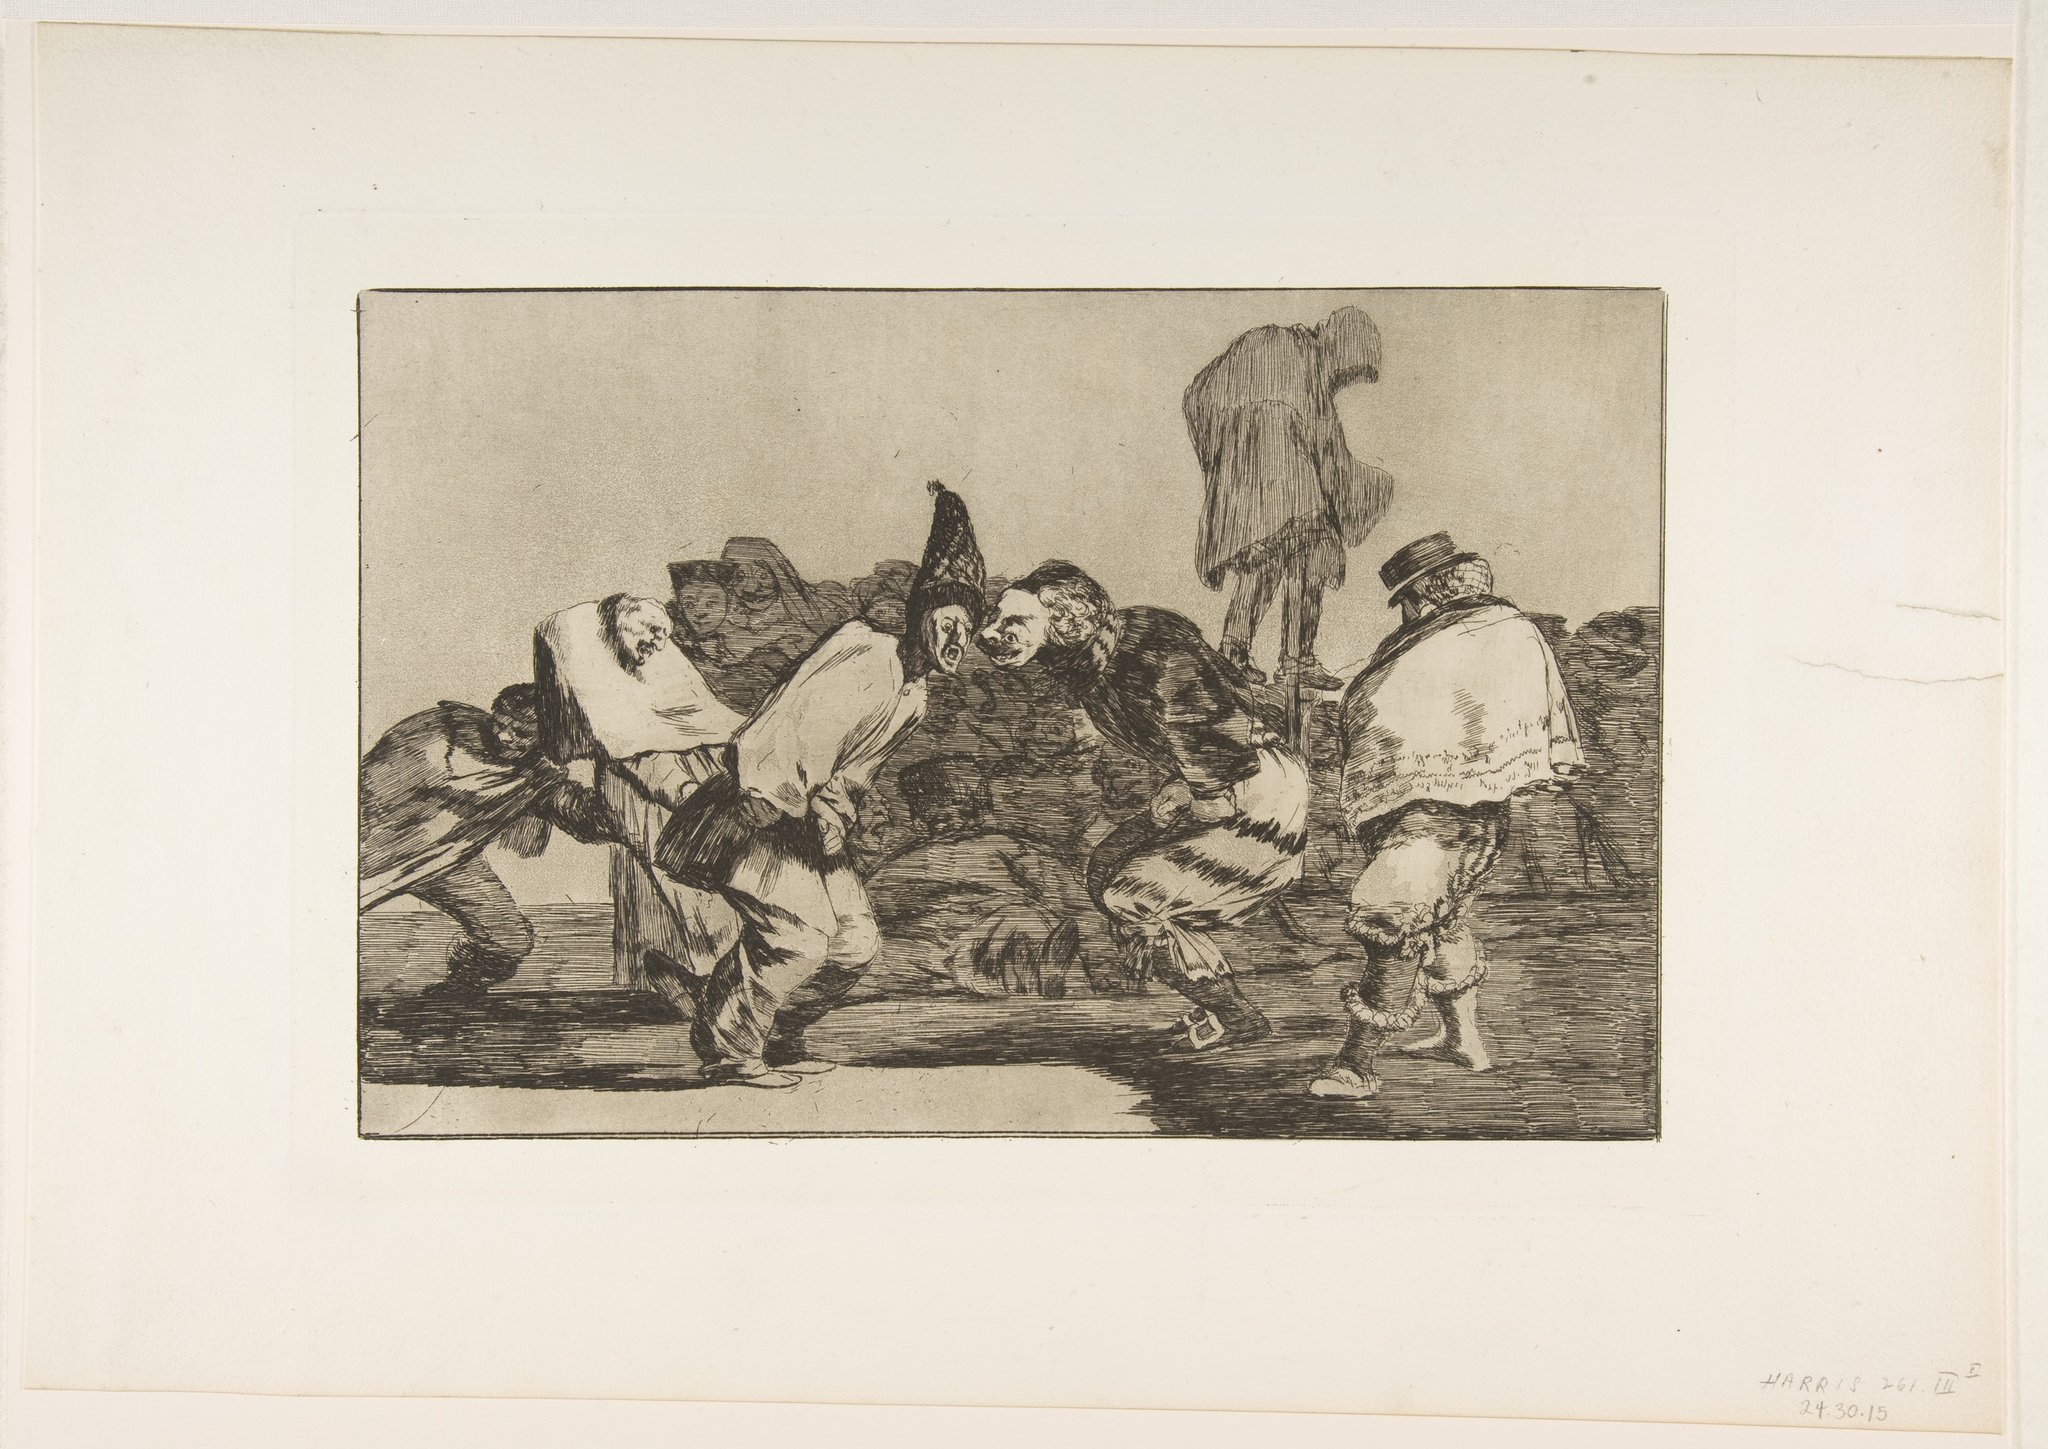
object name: print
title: Carnival Folly, from "The Disparates" (Follies / Irrationalities)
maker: goya (francisco de goya y lucientes)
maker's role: artist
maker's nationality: spanish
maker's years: 1746-1828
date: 1815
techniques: aquatint, etching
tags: masks,men